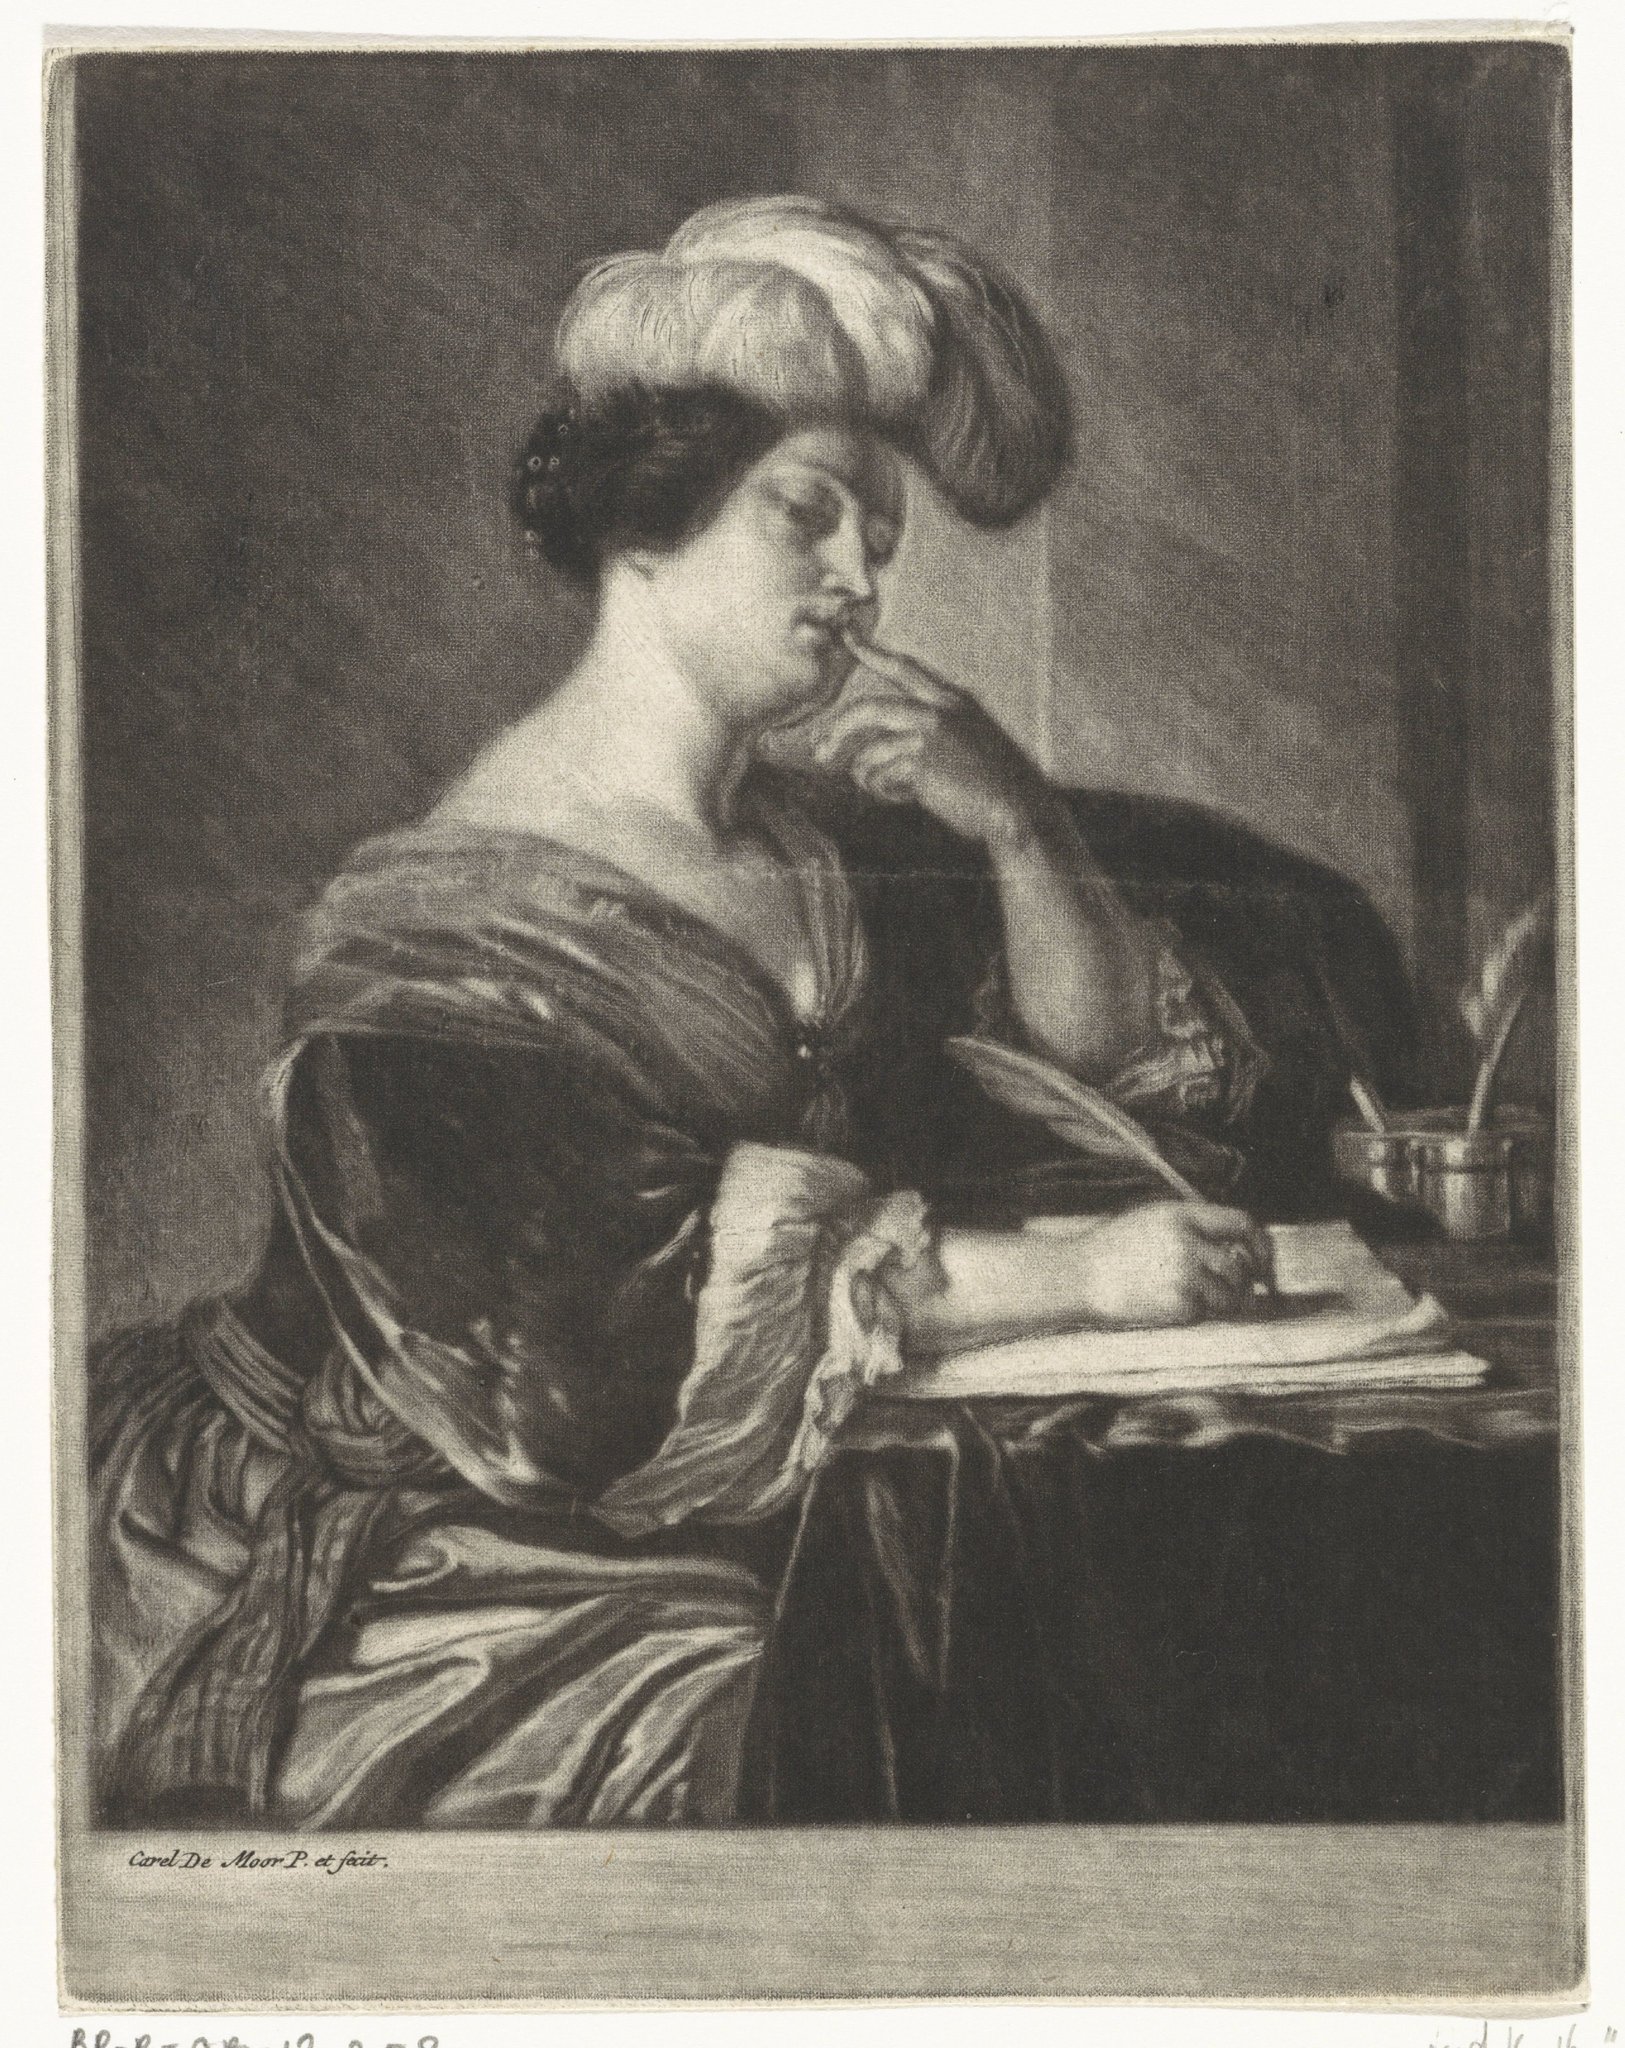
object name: print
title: Portret van een schrijvende vrouw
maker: carel de moor (ii)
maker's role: draughtsman, painter, print maker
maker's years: 1655-1738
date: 1666-1738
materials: paper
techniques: engraving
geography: northern netherlands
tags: quill, handwriting, written text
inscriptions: collector's mark: Lugt 240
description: Aan een bureau zit een vrouw te schrijven. Ze heeft een van haar vingers naar haar lippen gebracht. Ze draagt een hoofdtooi met veren.